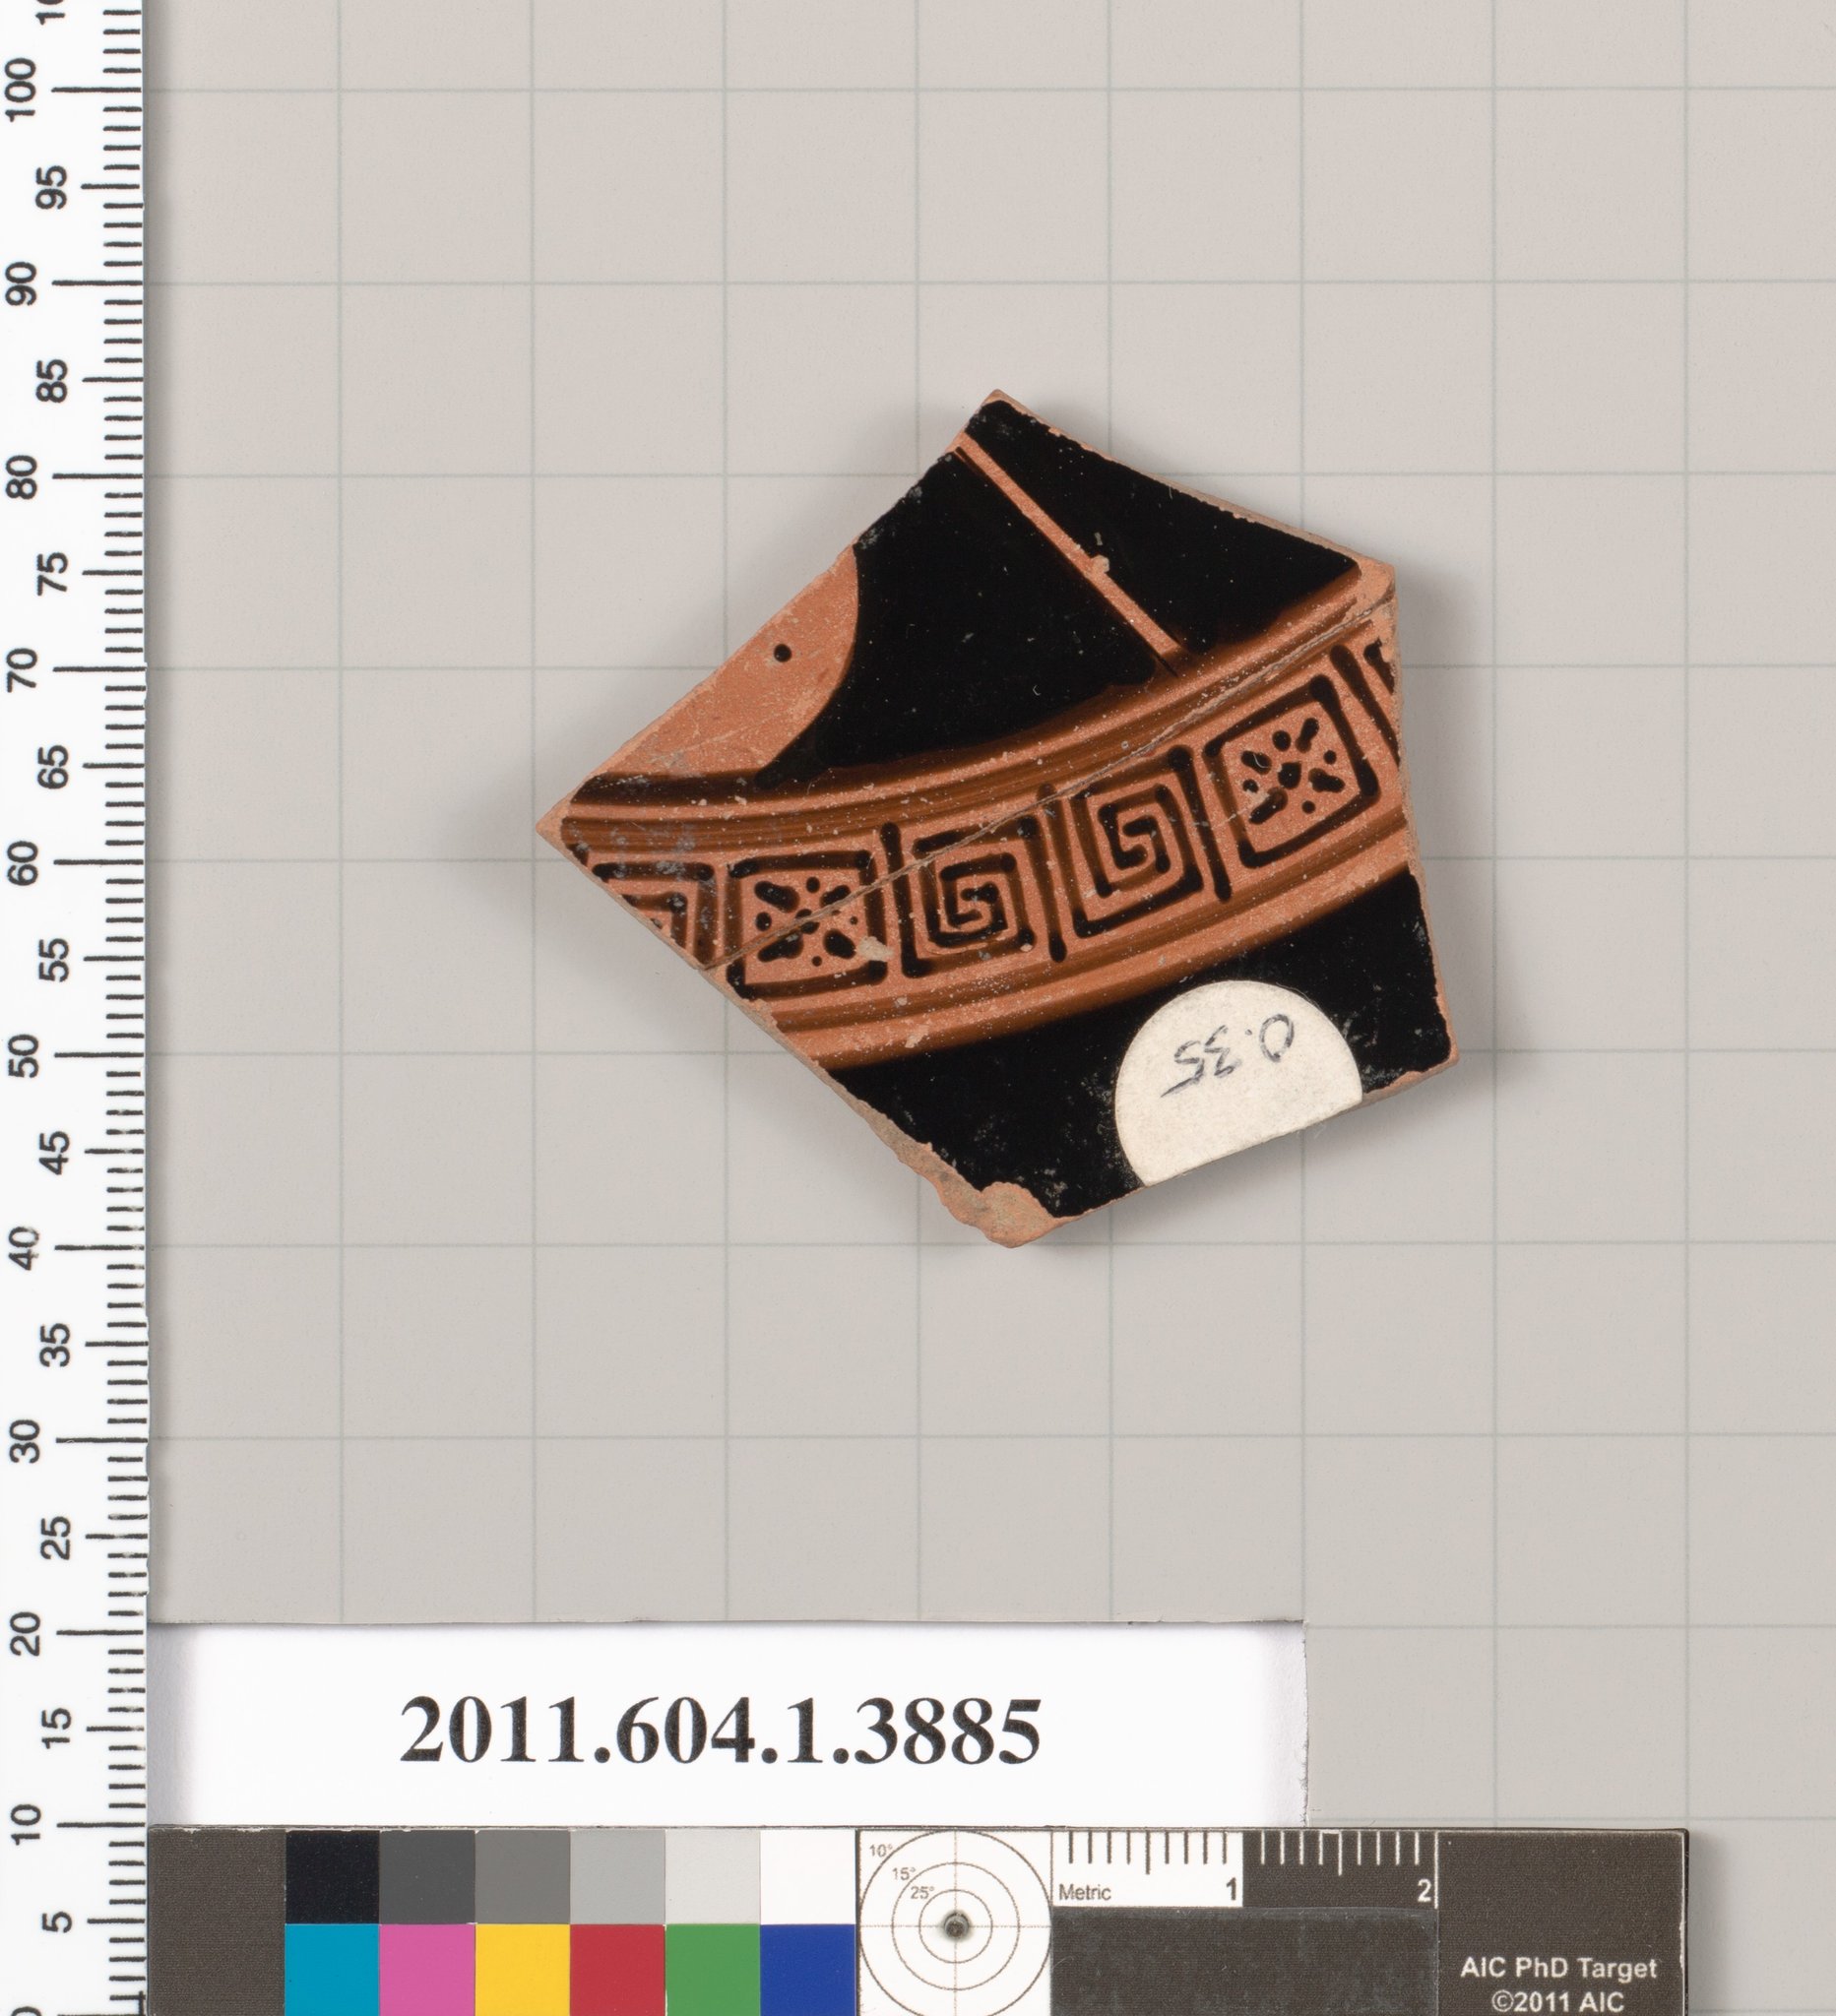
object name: kylix fragment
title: Terracotta fragment of a kylix (drinking cup)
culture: greek, attic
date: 500-476 BCE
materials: terracotta